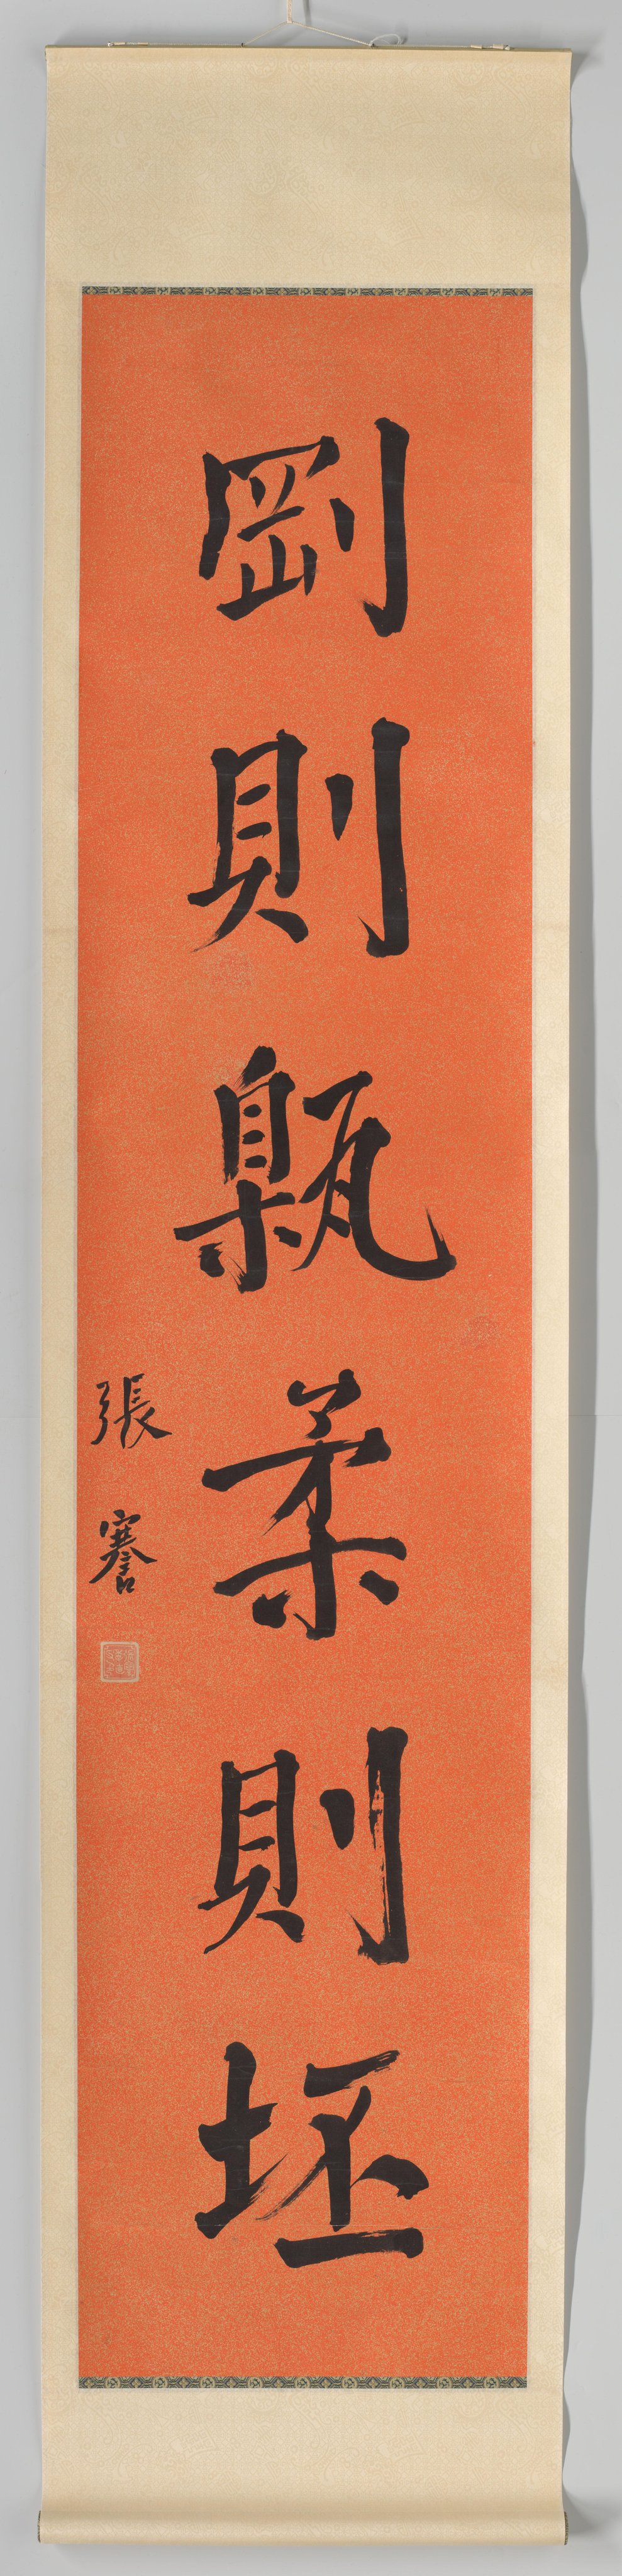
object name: hanging scroll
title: Calligraphy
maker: zhang jian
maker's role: painter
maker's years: 1853-1926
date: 1900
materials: ink, paper, silk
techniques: calligraphy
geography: china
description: This pair of calligraphy scrolls is a gift from a scholar to his scholar friend to hang in the study. The texts read in translation: ‘The things that are clean easily become dusty, the things that are white easily become dirty’ and (when making pottery) ‘when it is hard, it is easy to break, when it is soft it is easy to shape.’